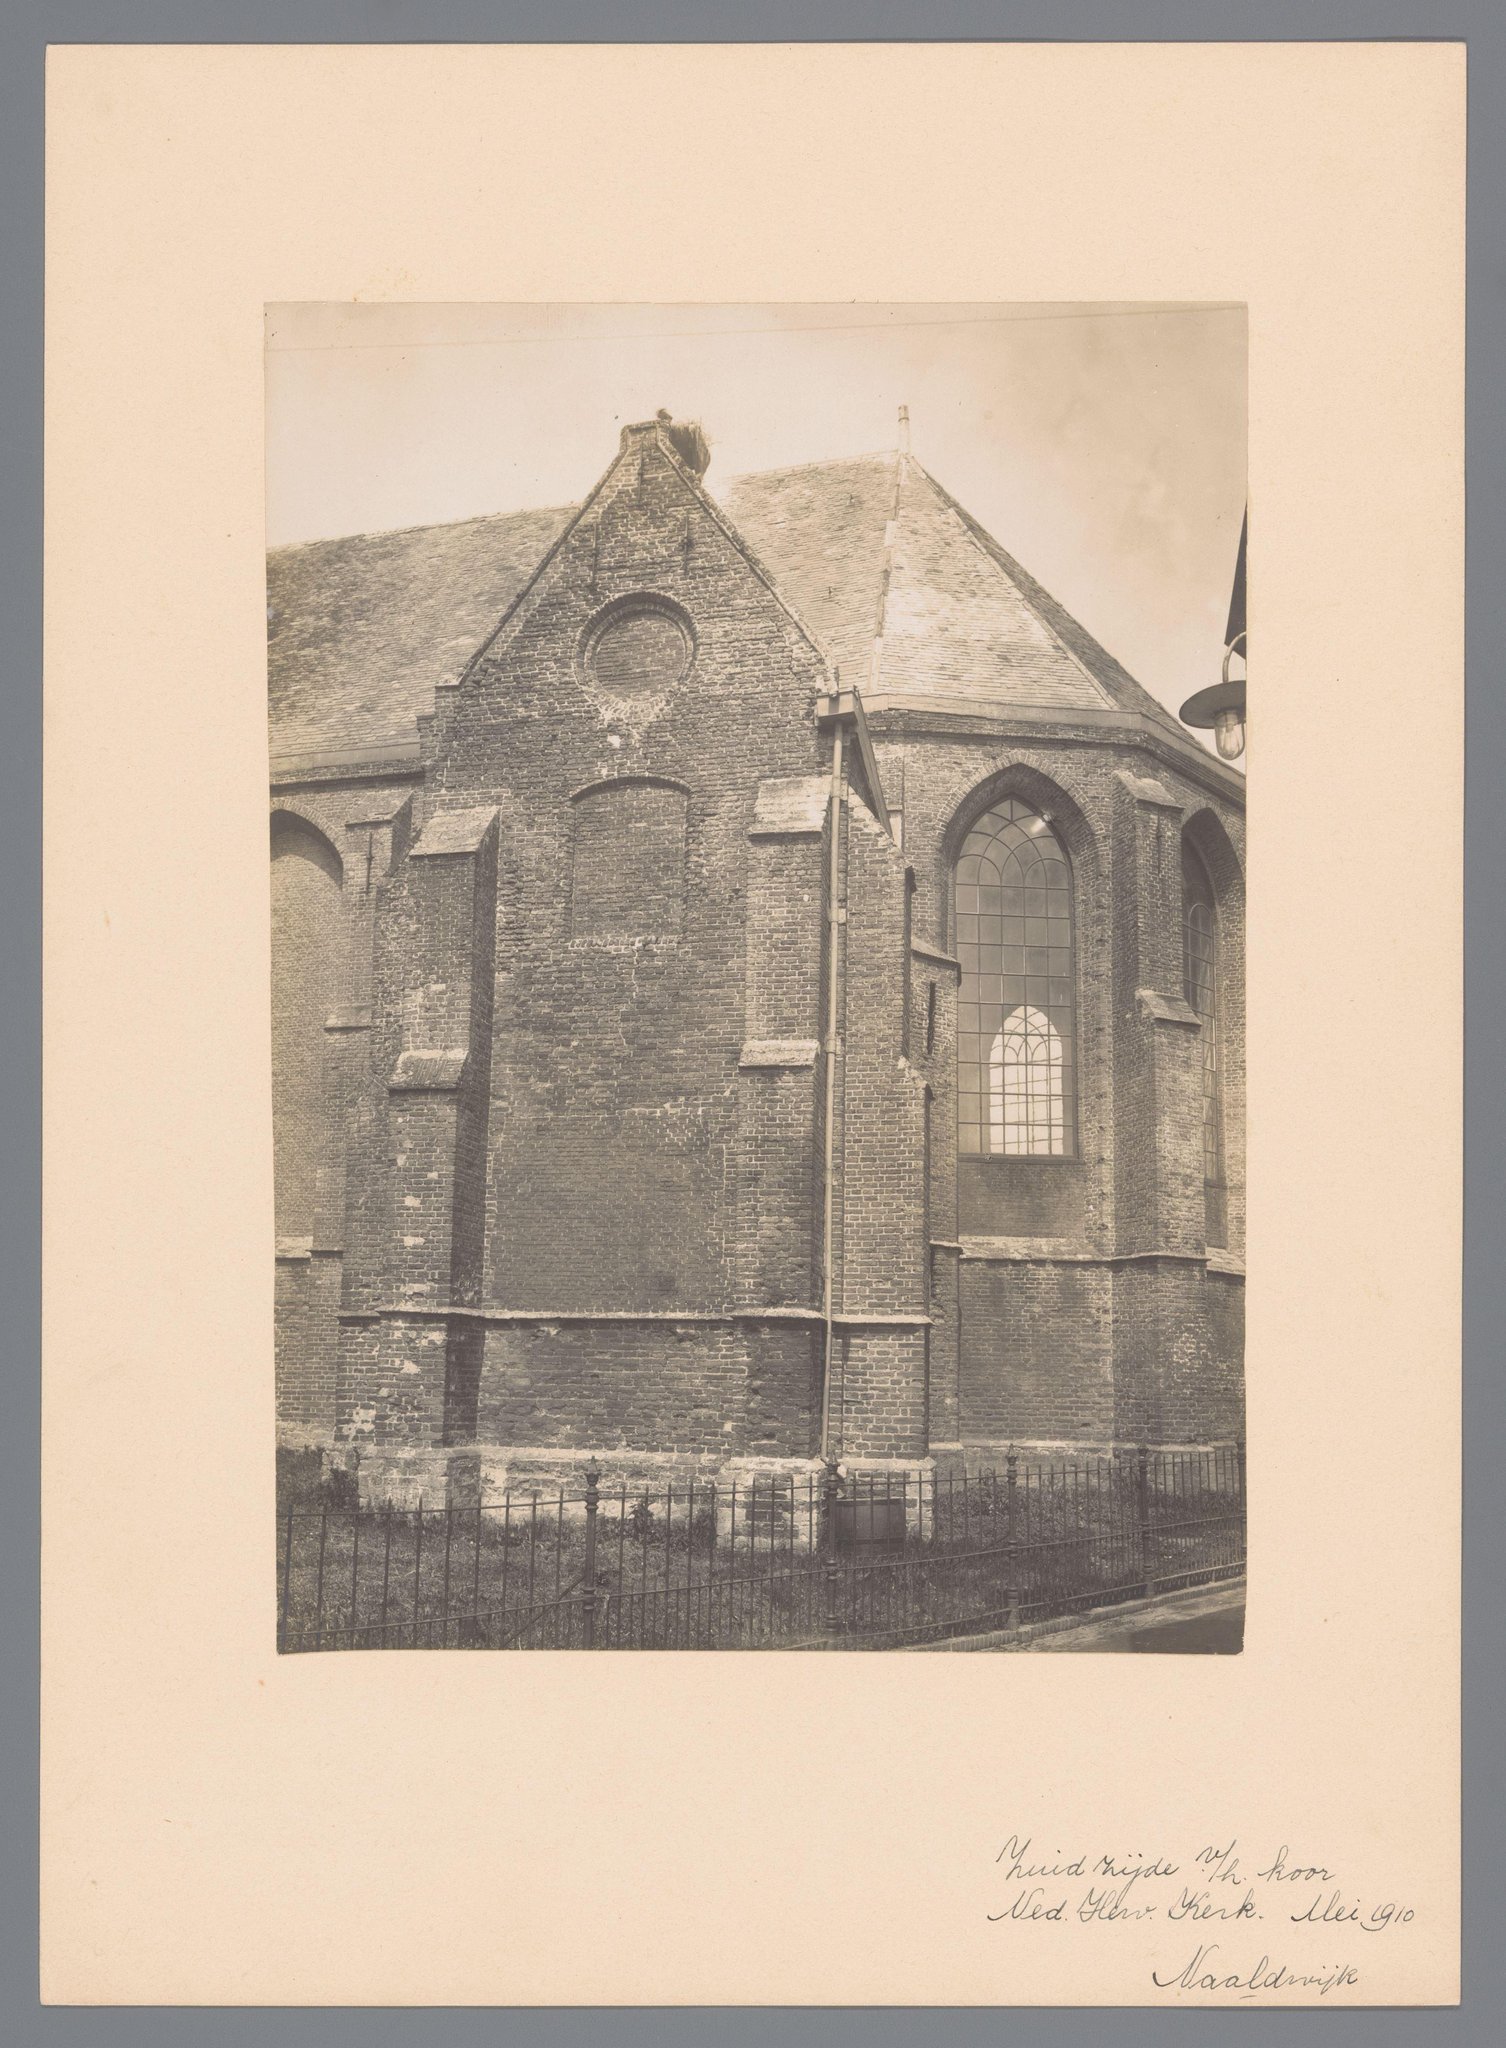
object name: photograph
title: Zuidzijde van het koor van de Oude kerk te Naaldwijk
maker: anoniem (monumentenzorg)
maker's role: fotograaf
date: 1910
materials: cardboard, photographic support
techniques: gelatin silver print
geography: naaldwijk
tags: parts of church exterior and annexes: choir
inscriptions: annotation: ‘Zuid zijde v/h koor/ Ned Herv. Kerk. Mei 1910/ Naaldwijk’, annotation: ‘J. Hoop of J. Popels/ ca. 1600’